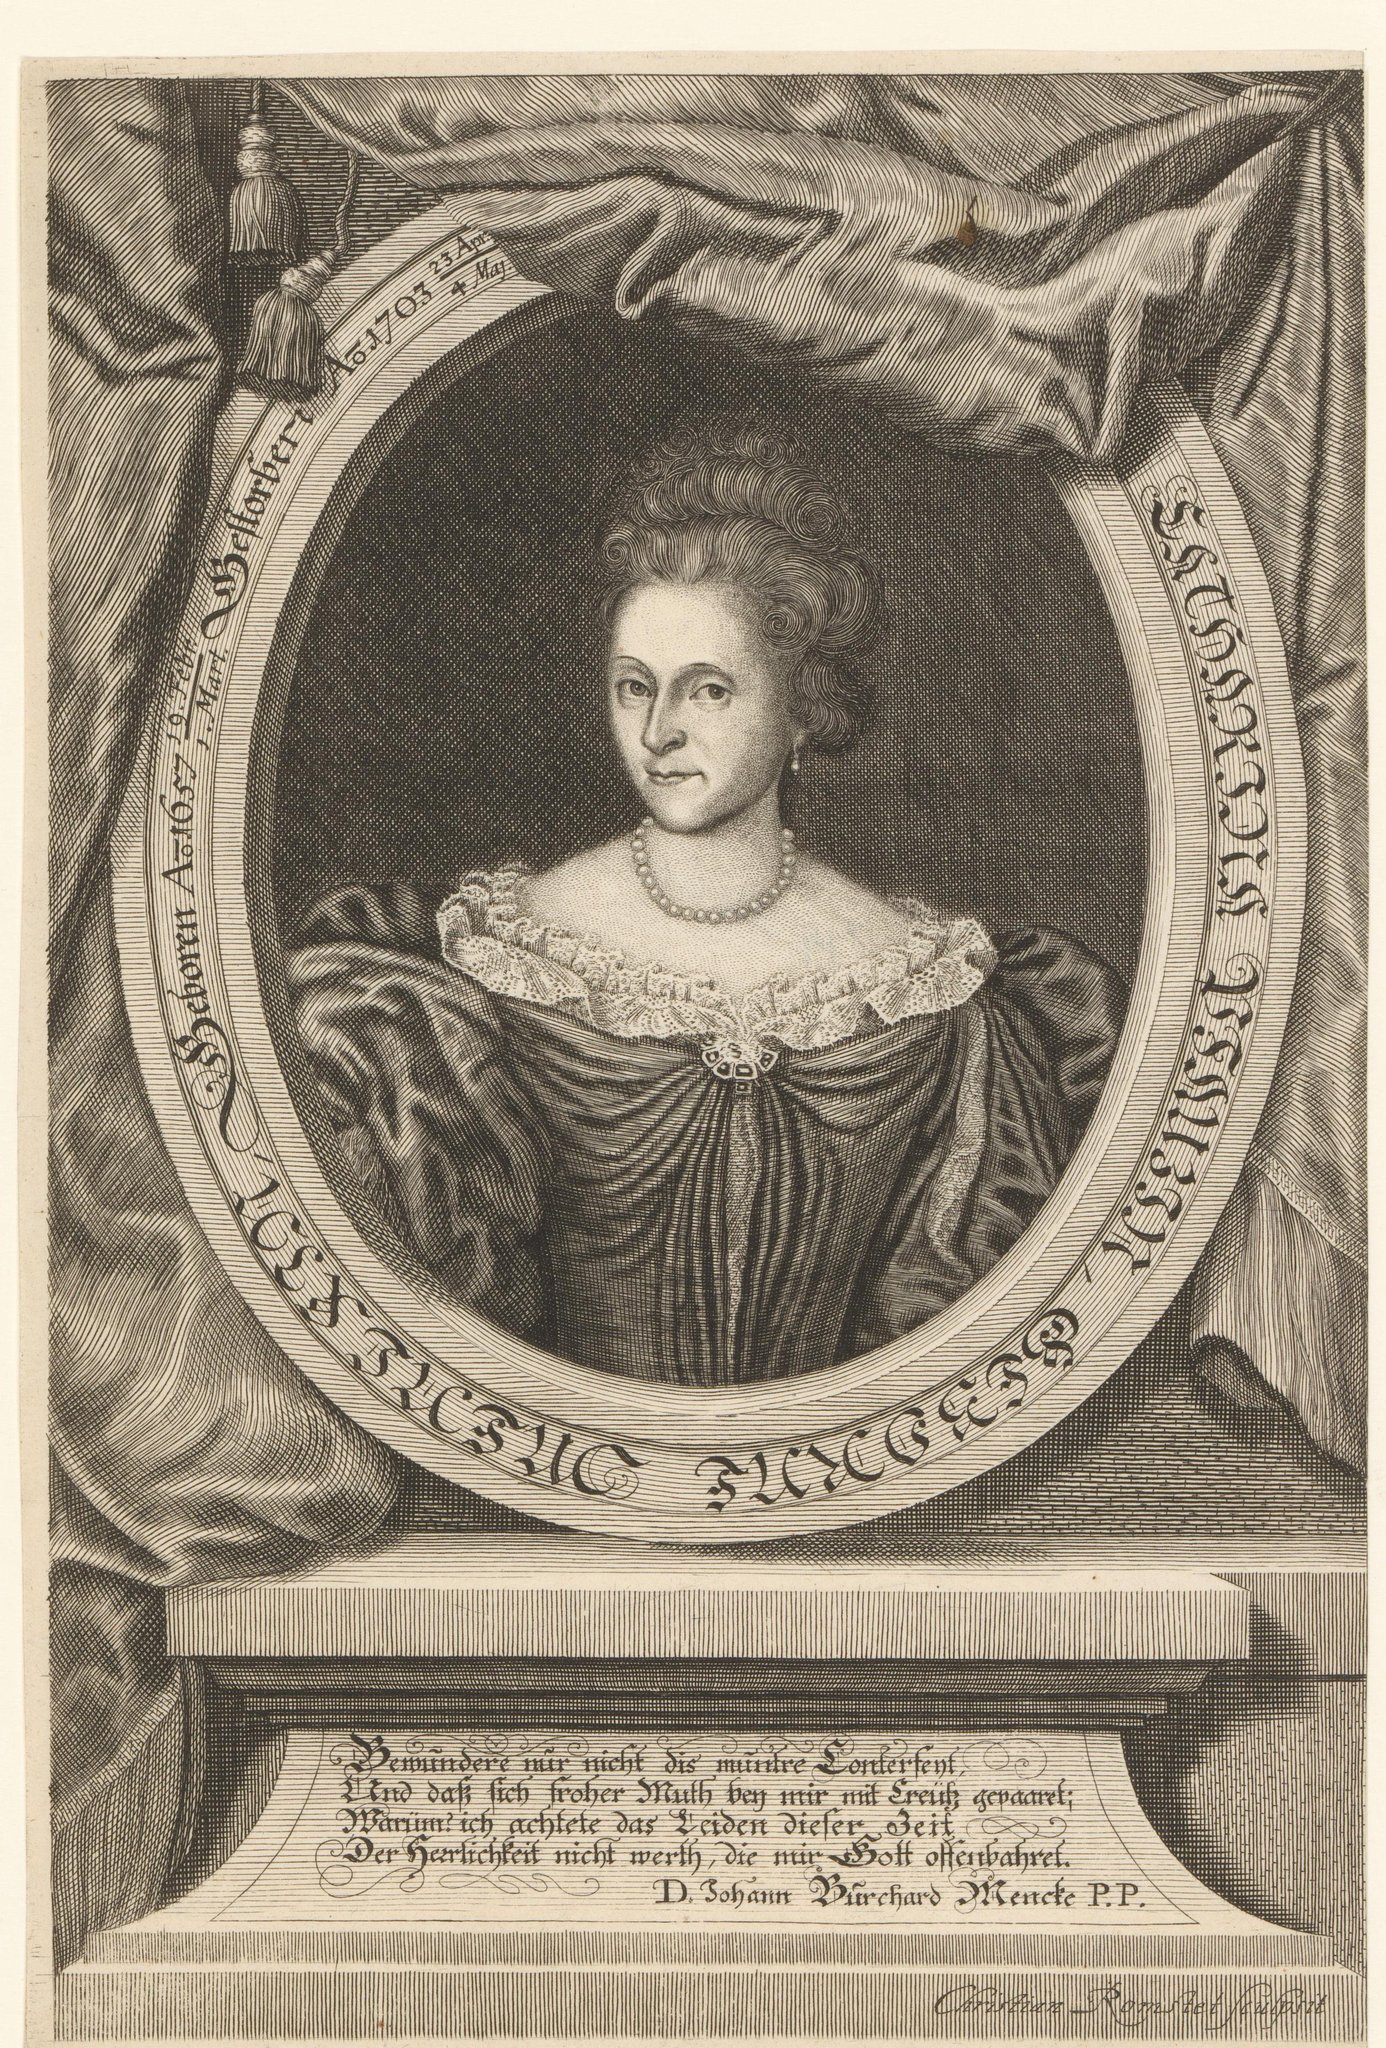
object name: print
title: Portret van Catharina Pfautz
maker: christian romstet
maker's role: print maker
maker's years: 1640-1721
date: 1703-1721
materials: paper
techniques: engraving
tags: historical persons - bb - woman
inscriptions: collector's mark: Lugt 2228